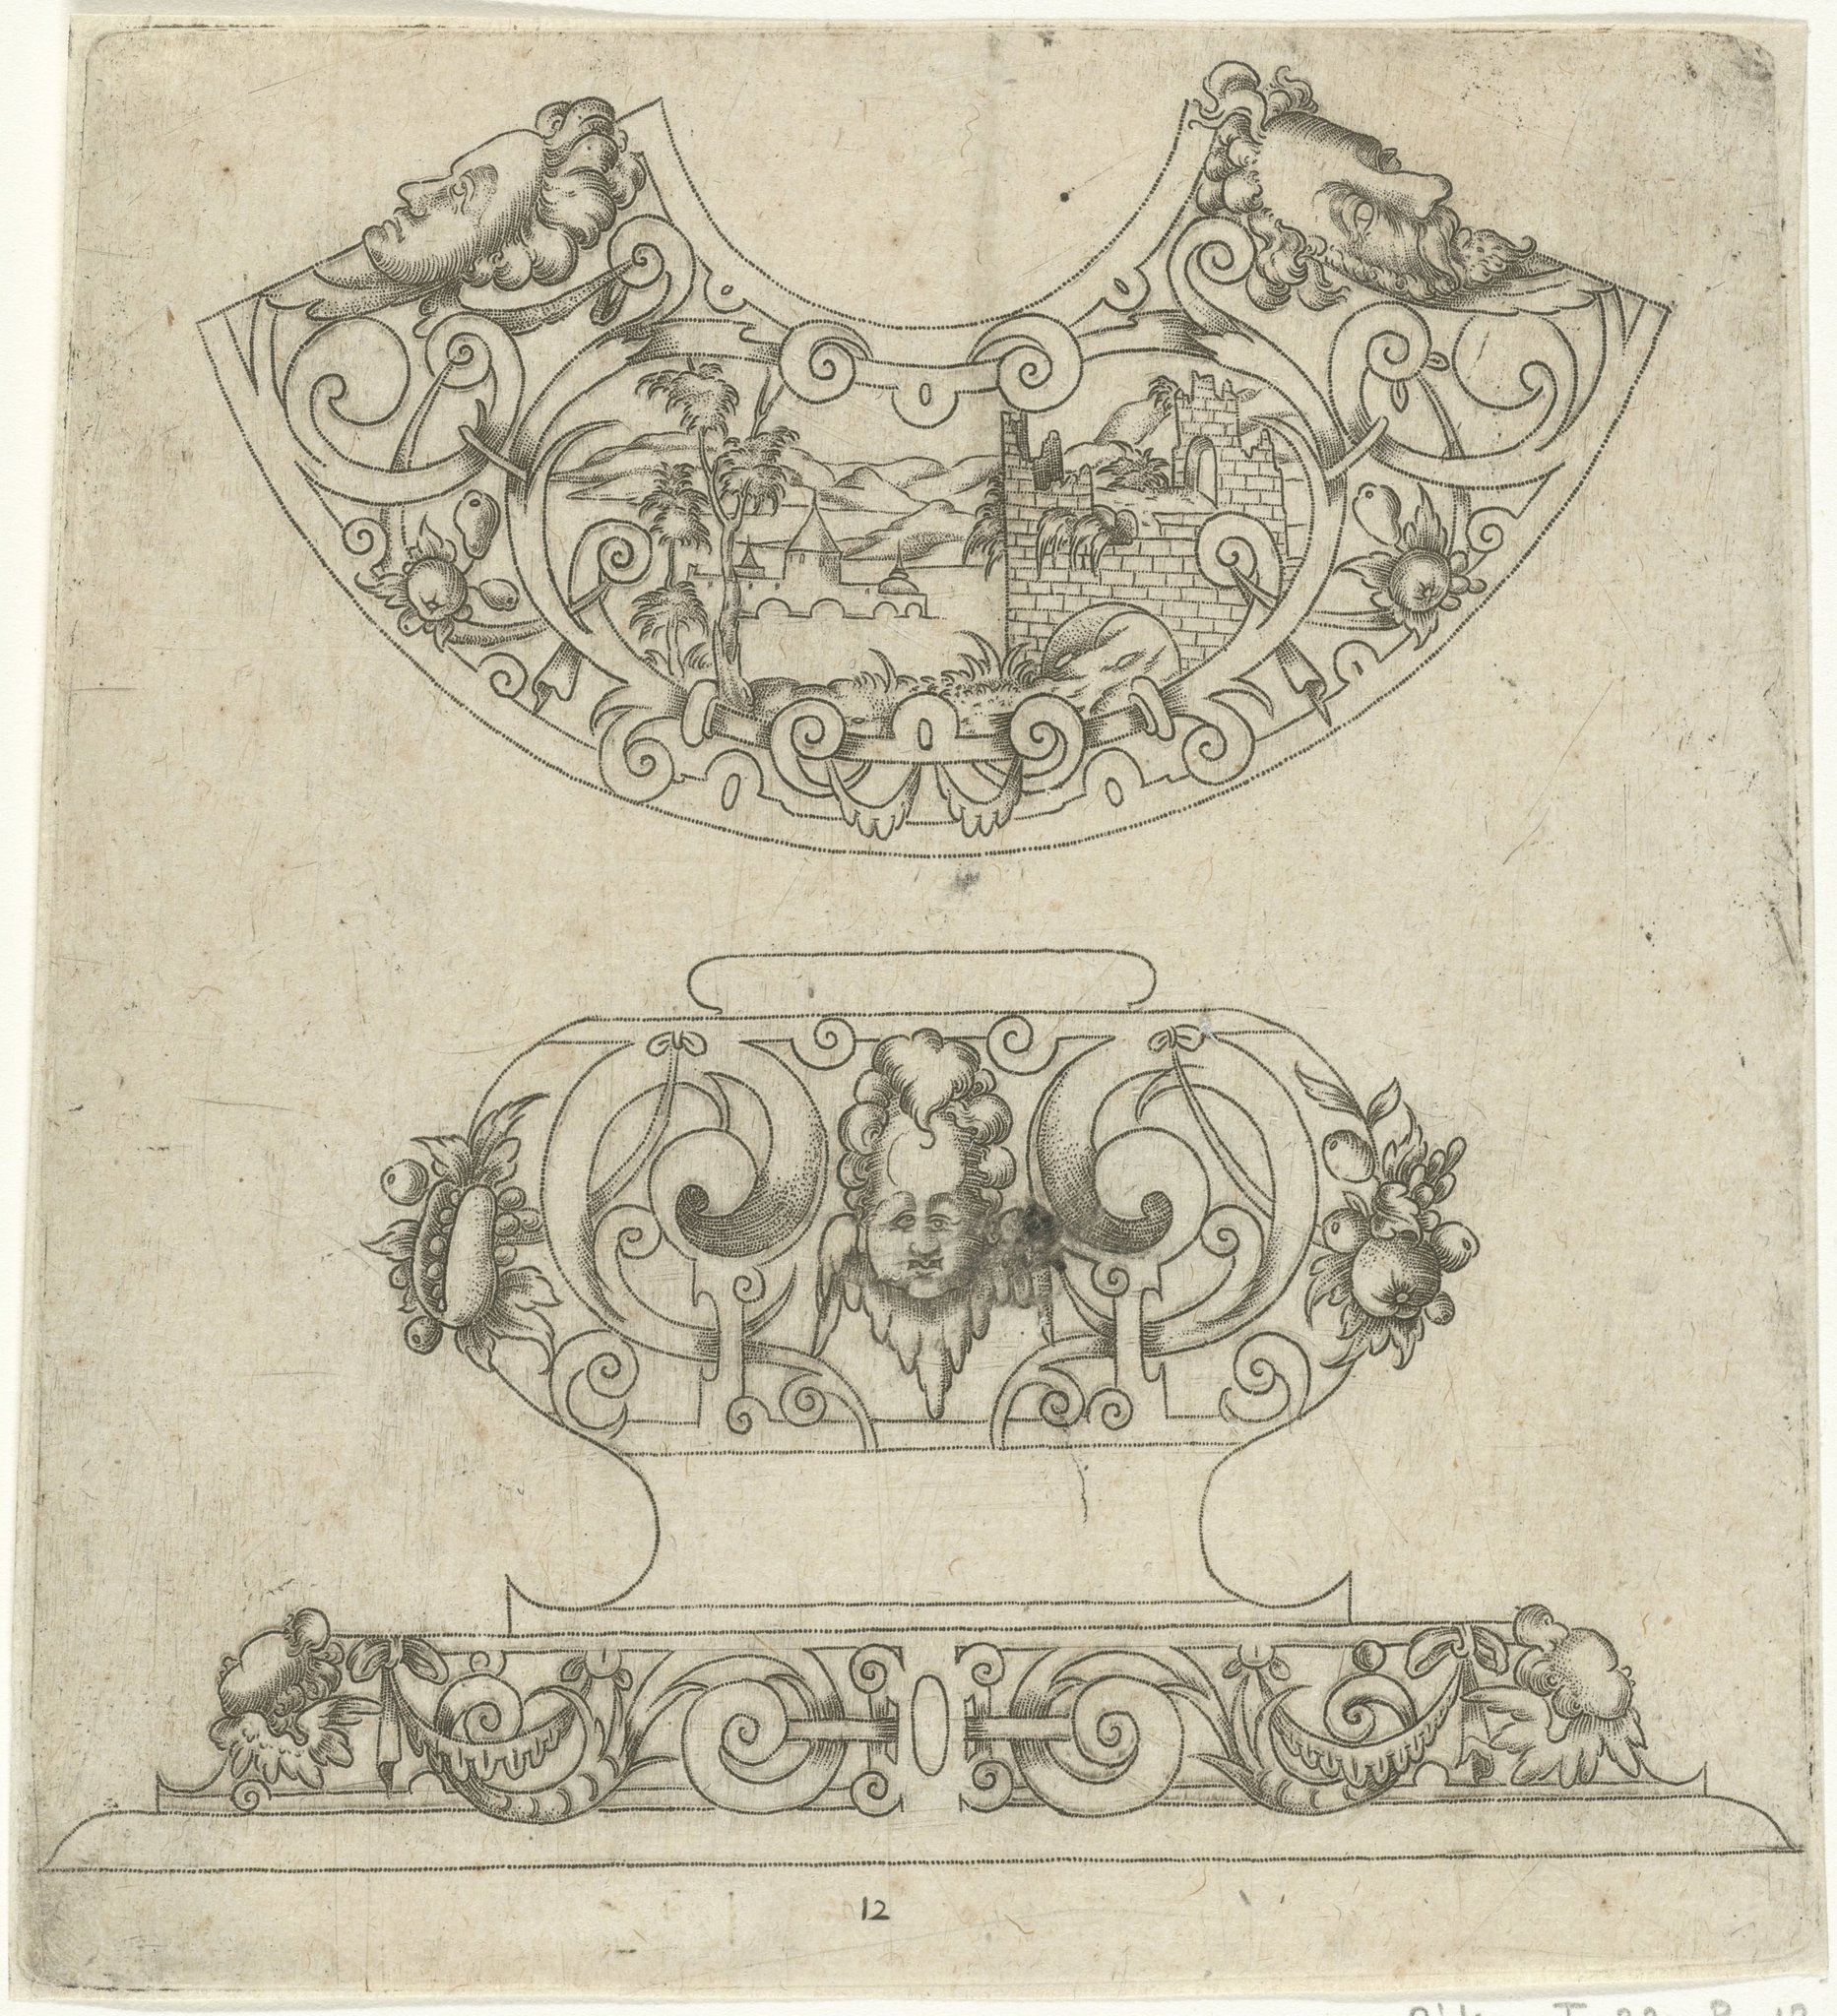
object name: ornament print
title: Veel schoene stucken om te drijven den Goudt smeden dienlijck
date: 1594-1635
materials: paper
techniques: engraving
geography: northern netherlands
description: De decoratie van de bovenzijde van de voet, bestaande uit een landschap in een liggend ovaal tussen twee mascarons, is boven de voet als een gebogen fries weergegeven. Tegenzijdige kopieën van de onder Orn Cat I-324.A vermelde serie. Titelblad en 14 deels genummerde bladen uit een serie van 25.